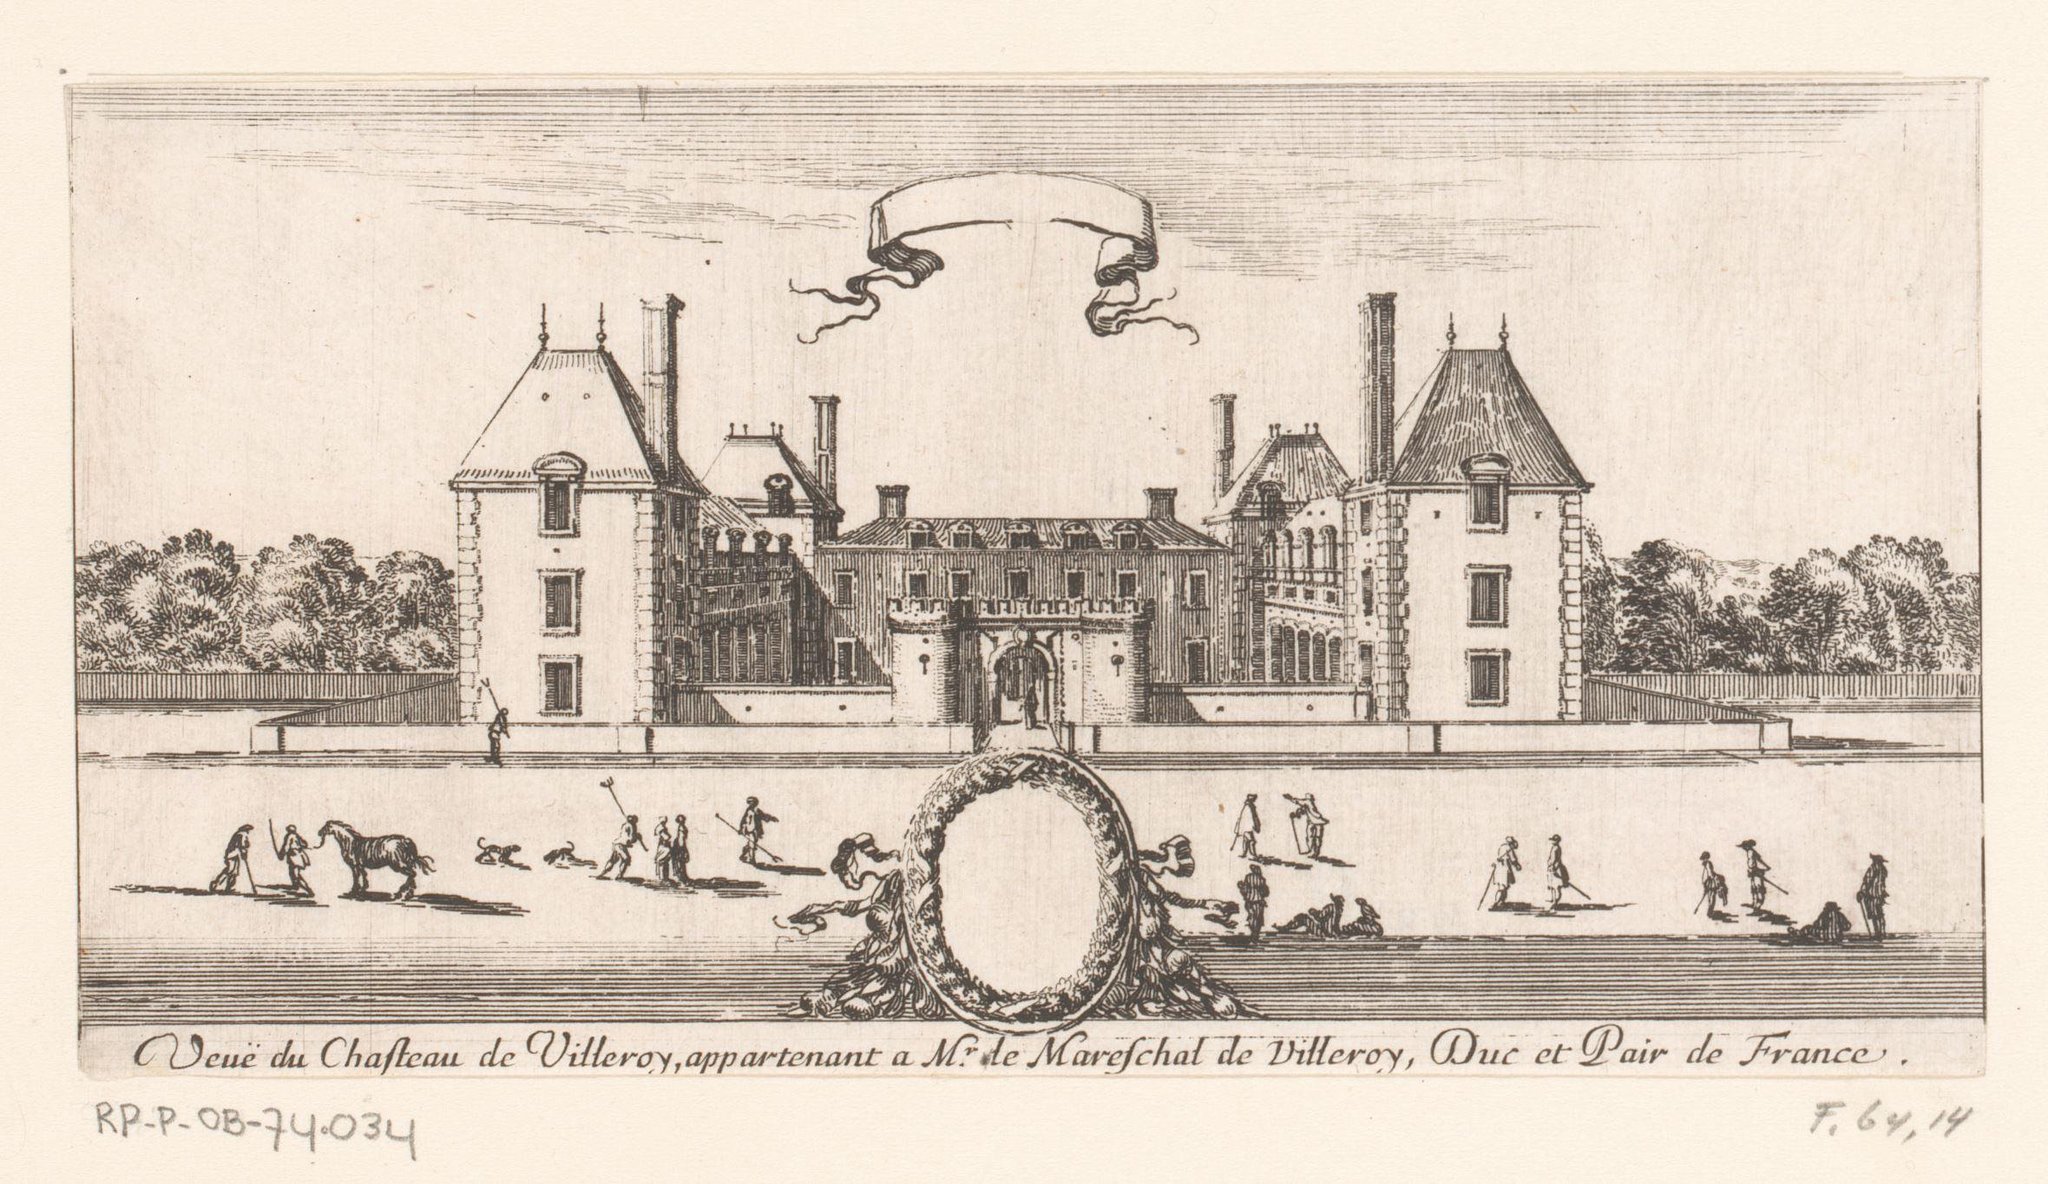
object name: print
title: Veue du Chasteau de Villeroy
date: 1652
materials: paper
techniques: engraving, etching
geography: paris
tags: landscape with tower or castle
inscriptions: collector's mark: Lugt 240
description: Prent maakt deel uit van een ongenummerde serie van 30 prenten.